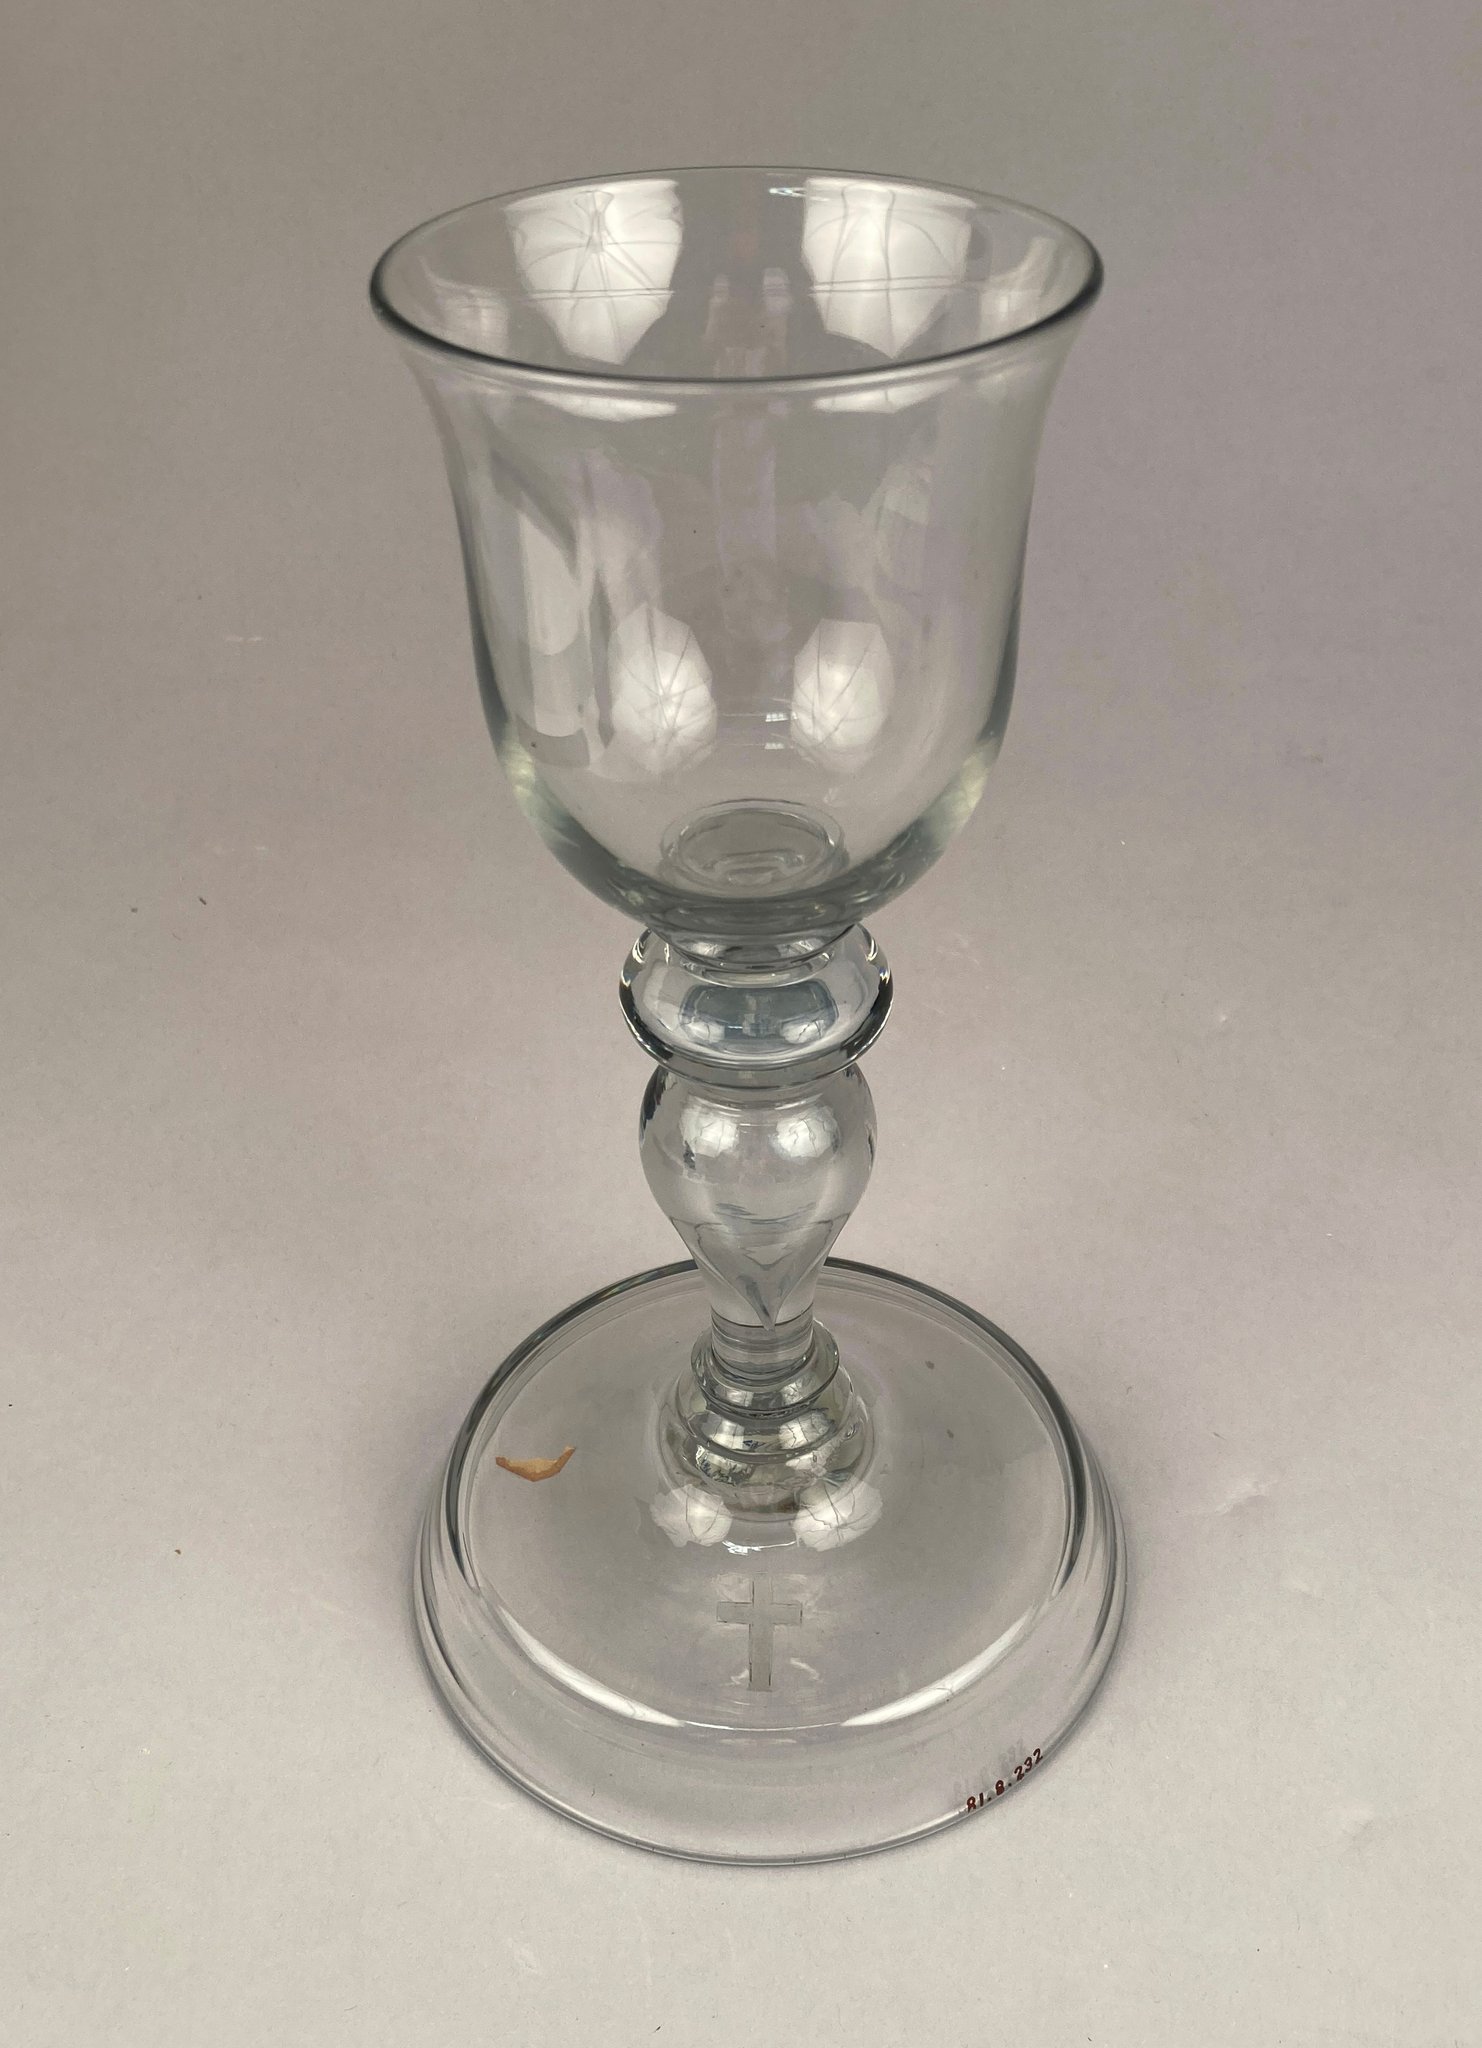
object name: chalice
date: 1801-1900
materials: glass